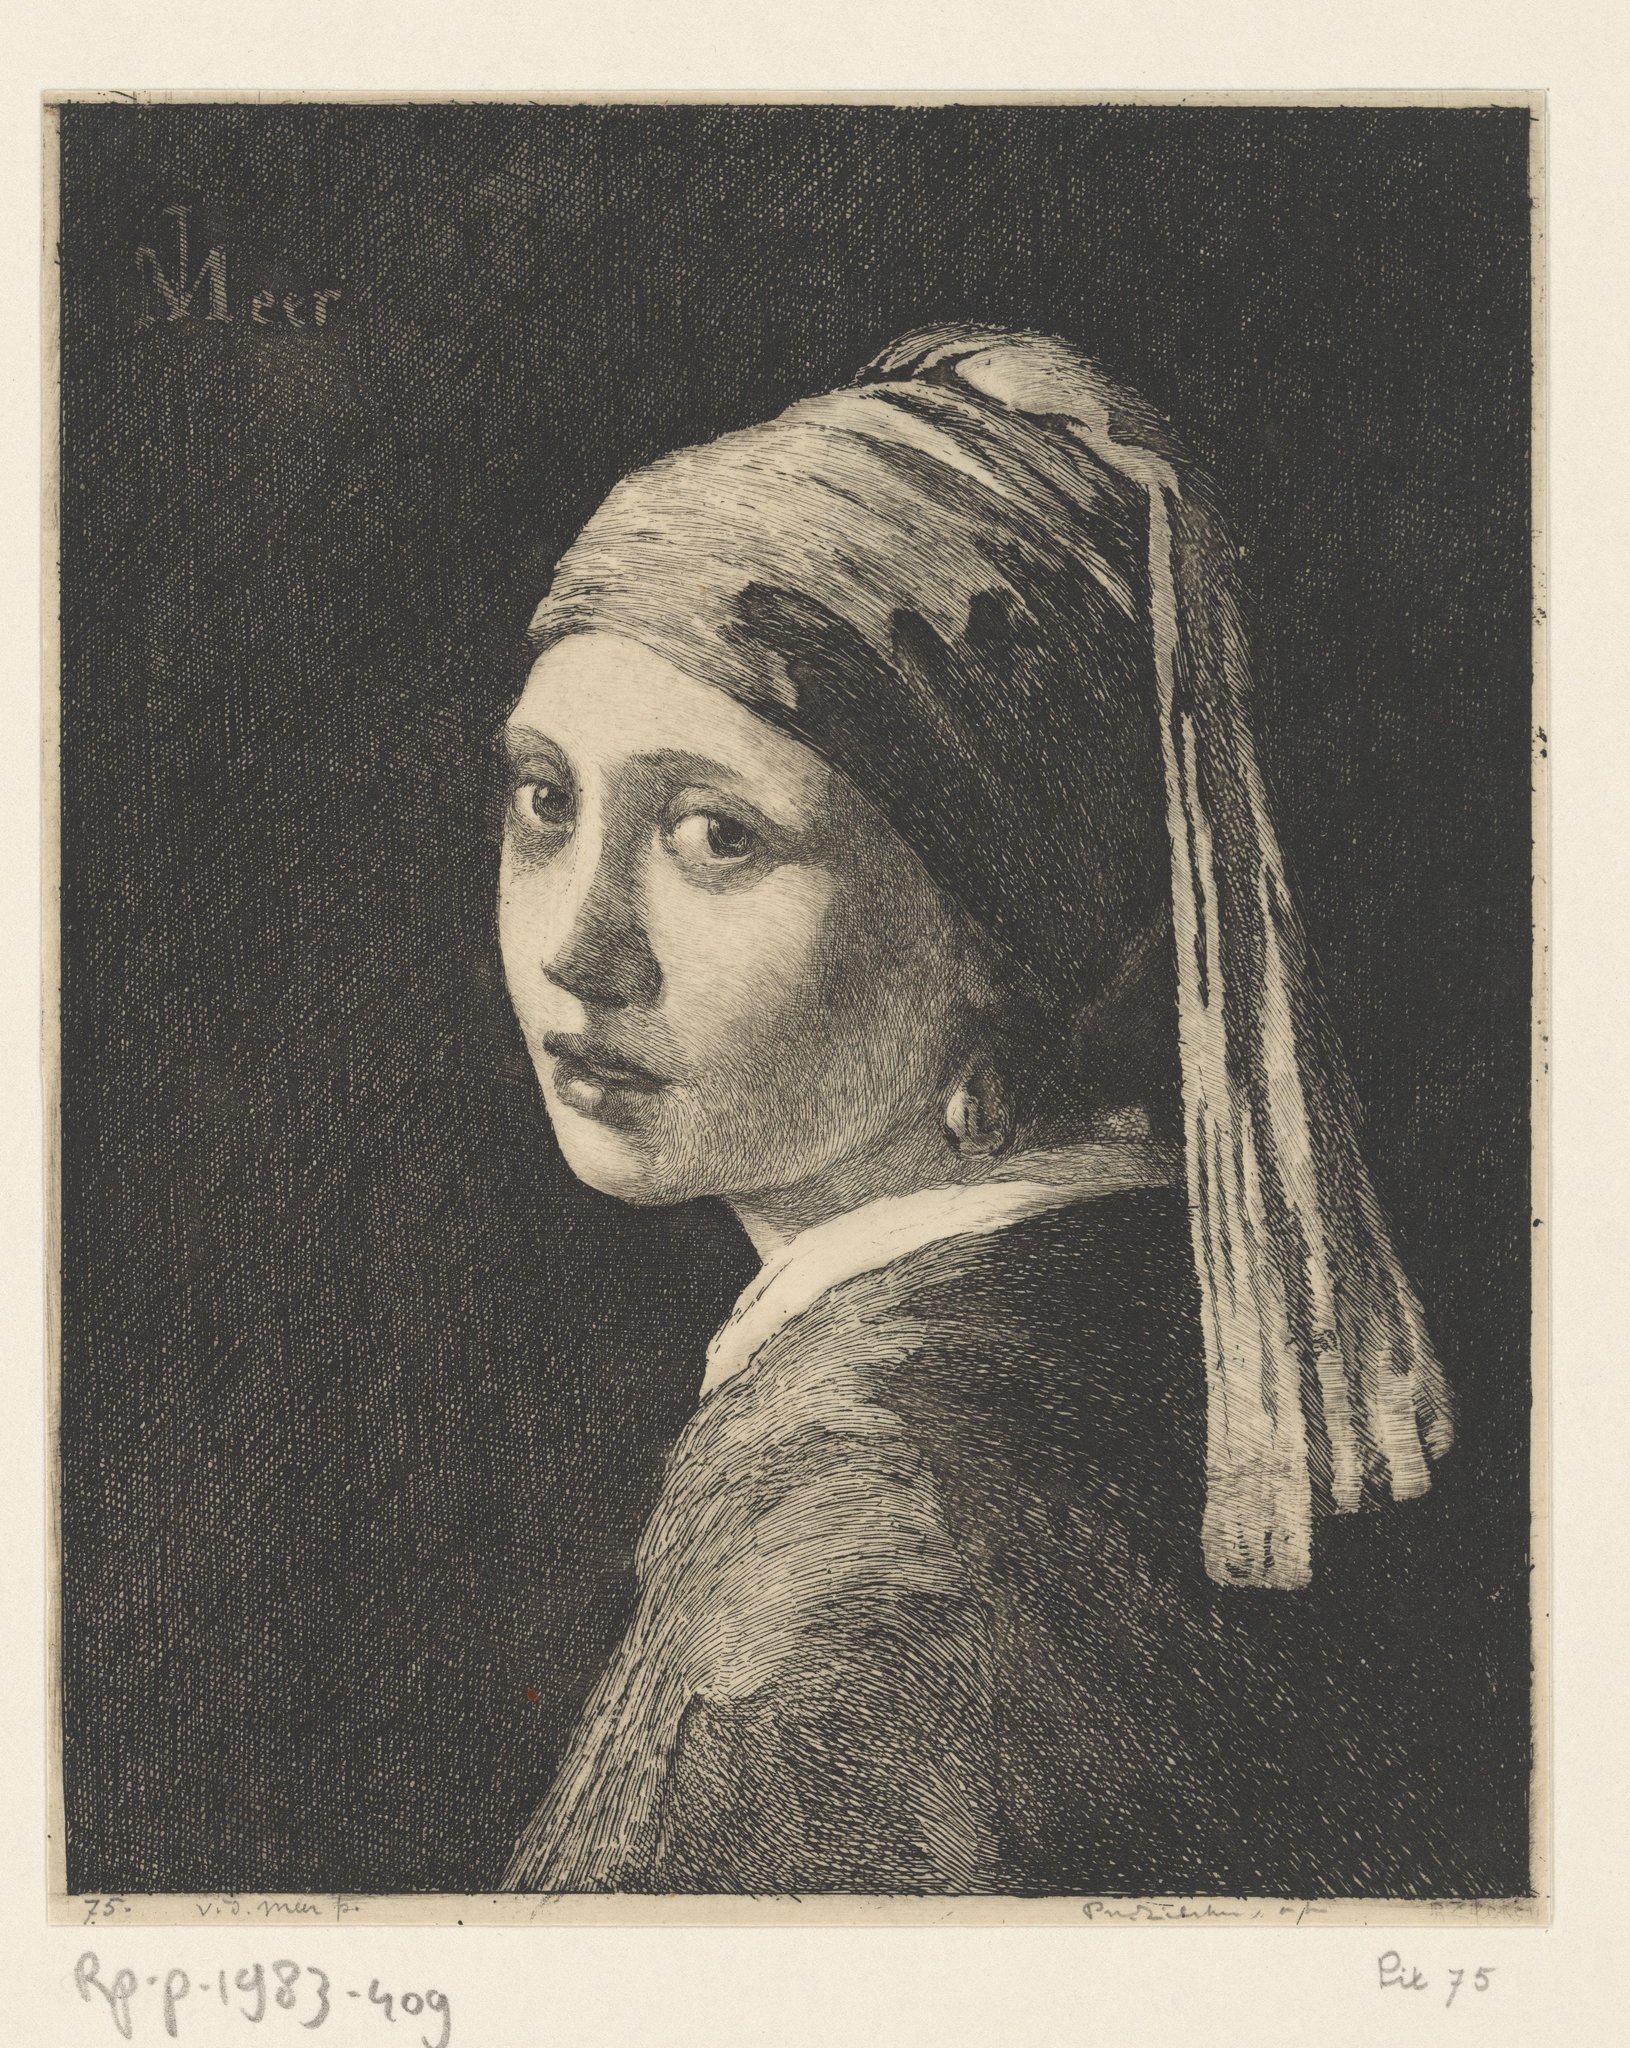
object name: print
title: Meisje met de parel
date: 1867-1890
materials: paper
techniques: drypoint, etching, intaglio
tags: girl (child between toddler and youth), pearl; pearl necklace, ear-rings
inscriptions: collector's mark: Lugt 2228